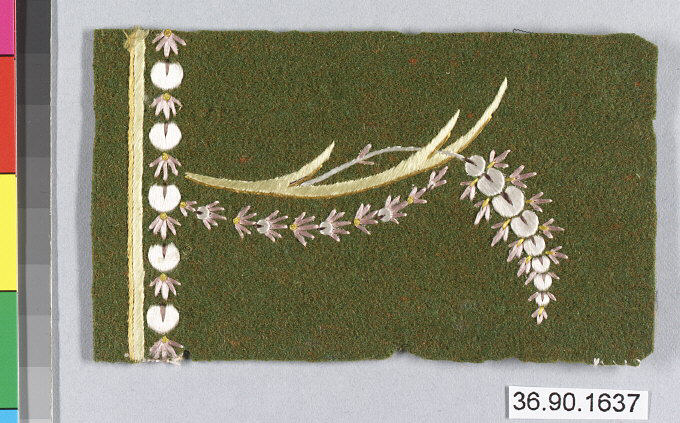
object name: sample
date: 1801-1833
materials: felt, silk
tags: flowers